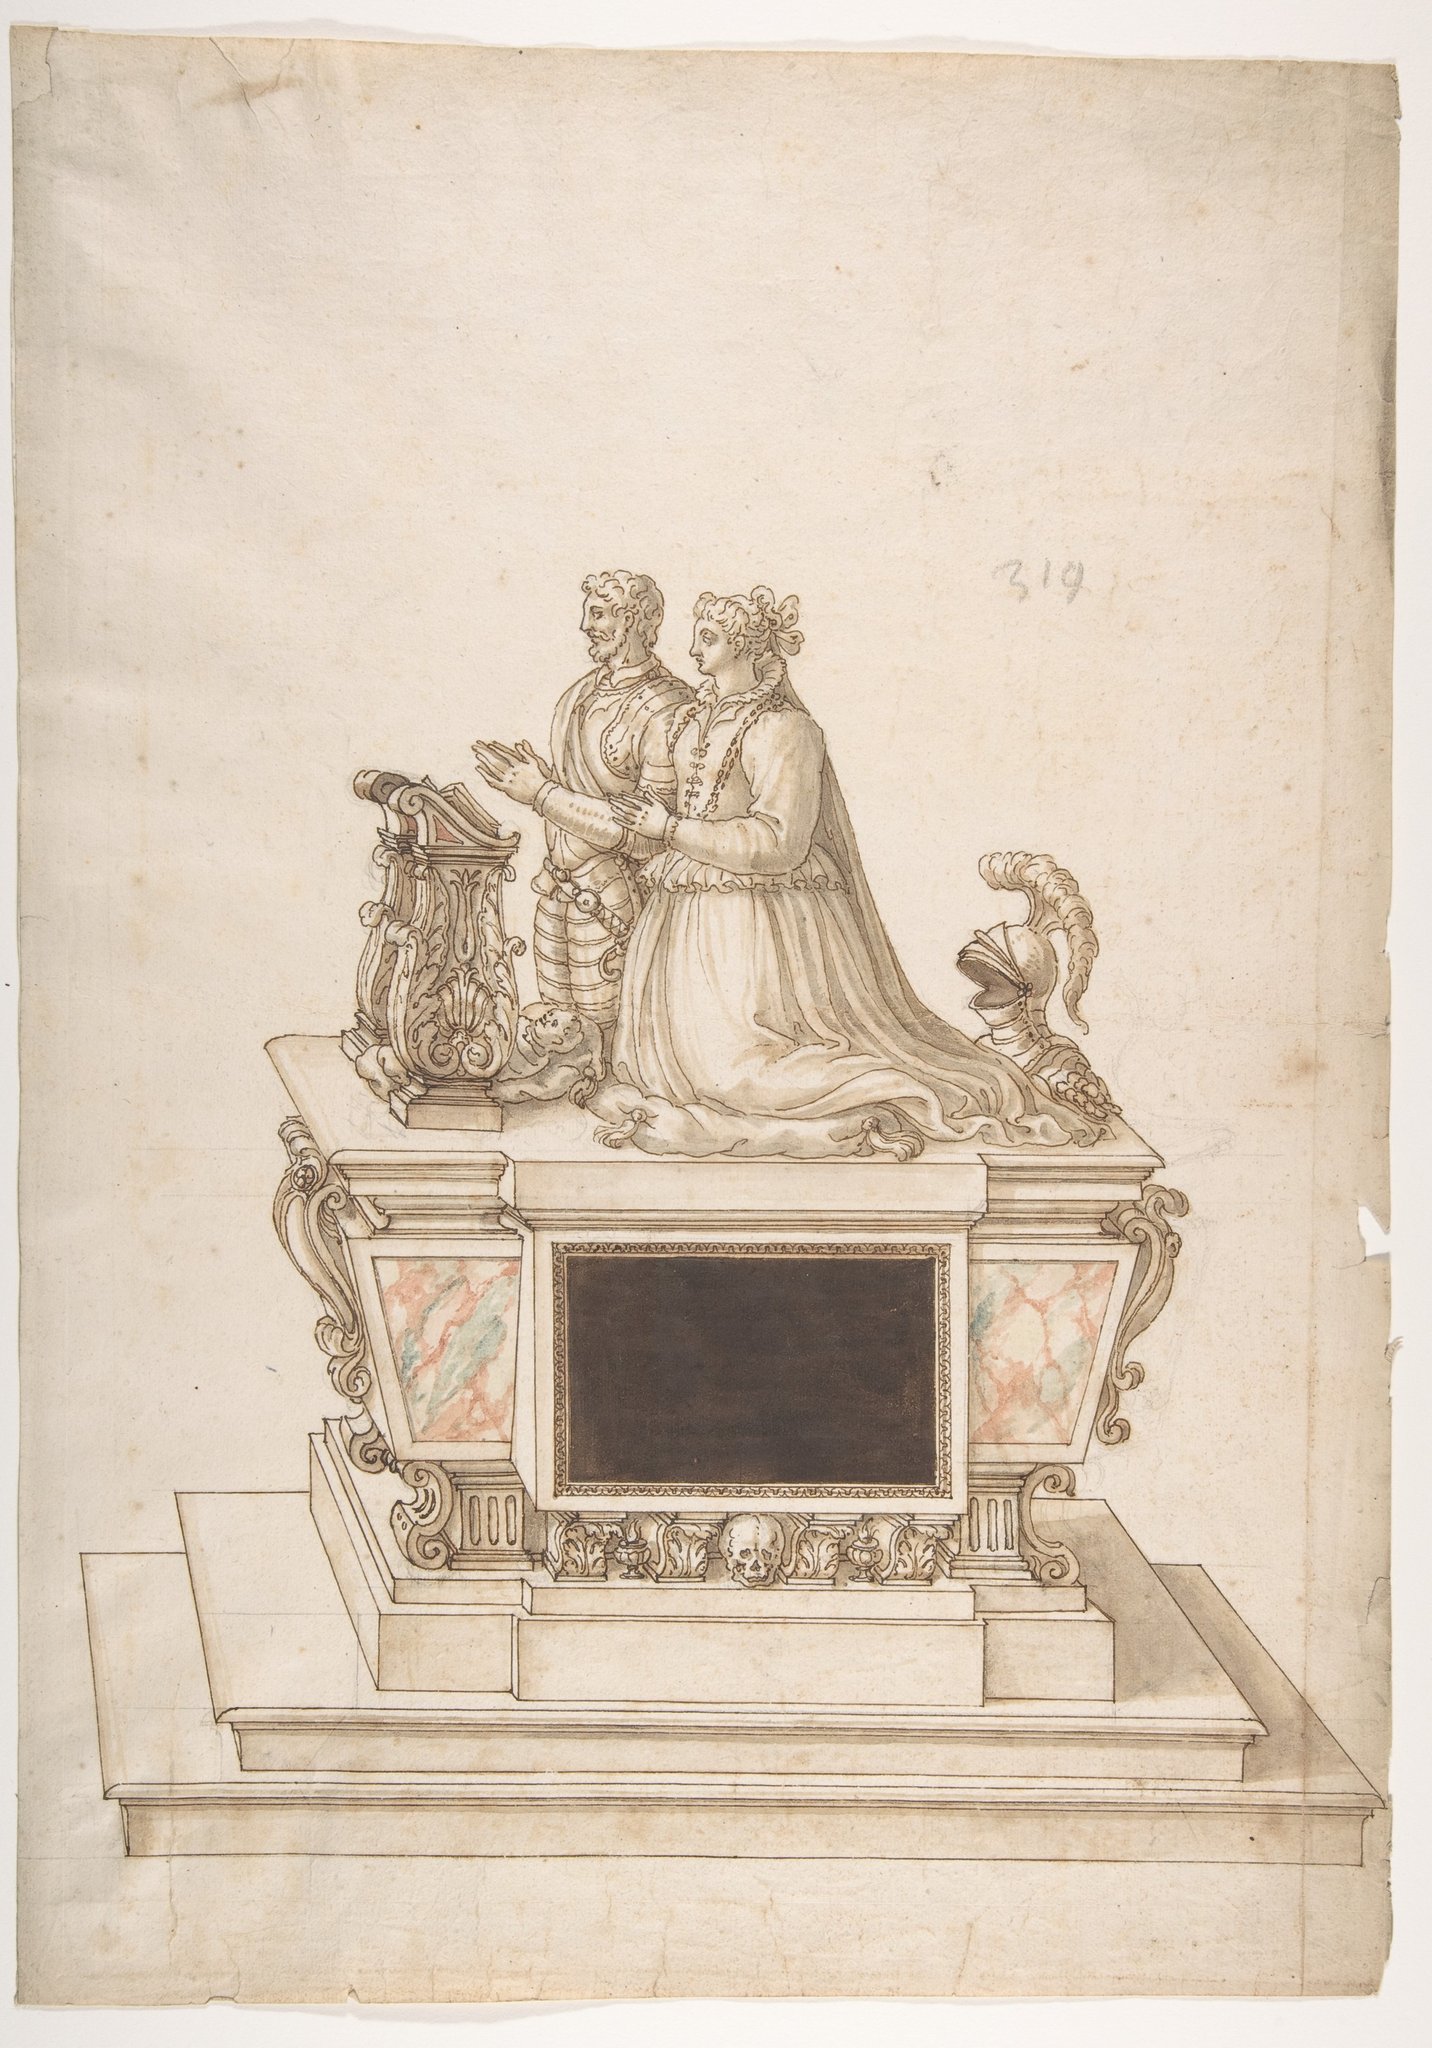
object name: drawing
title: Design for a Triple Tomb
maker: anonymous, french, 16th century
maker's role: artist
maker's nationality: french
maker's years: 1500-1600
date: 1501-1600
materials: chalk, ink, watercolor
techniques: brush, pen, wash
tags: tombs,men,women